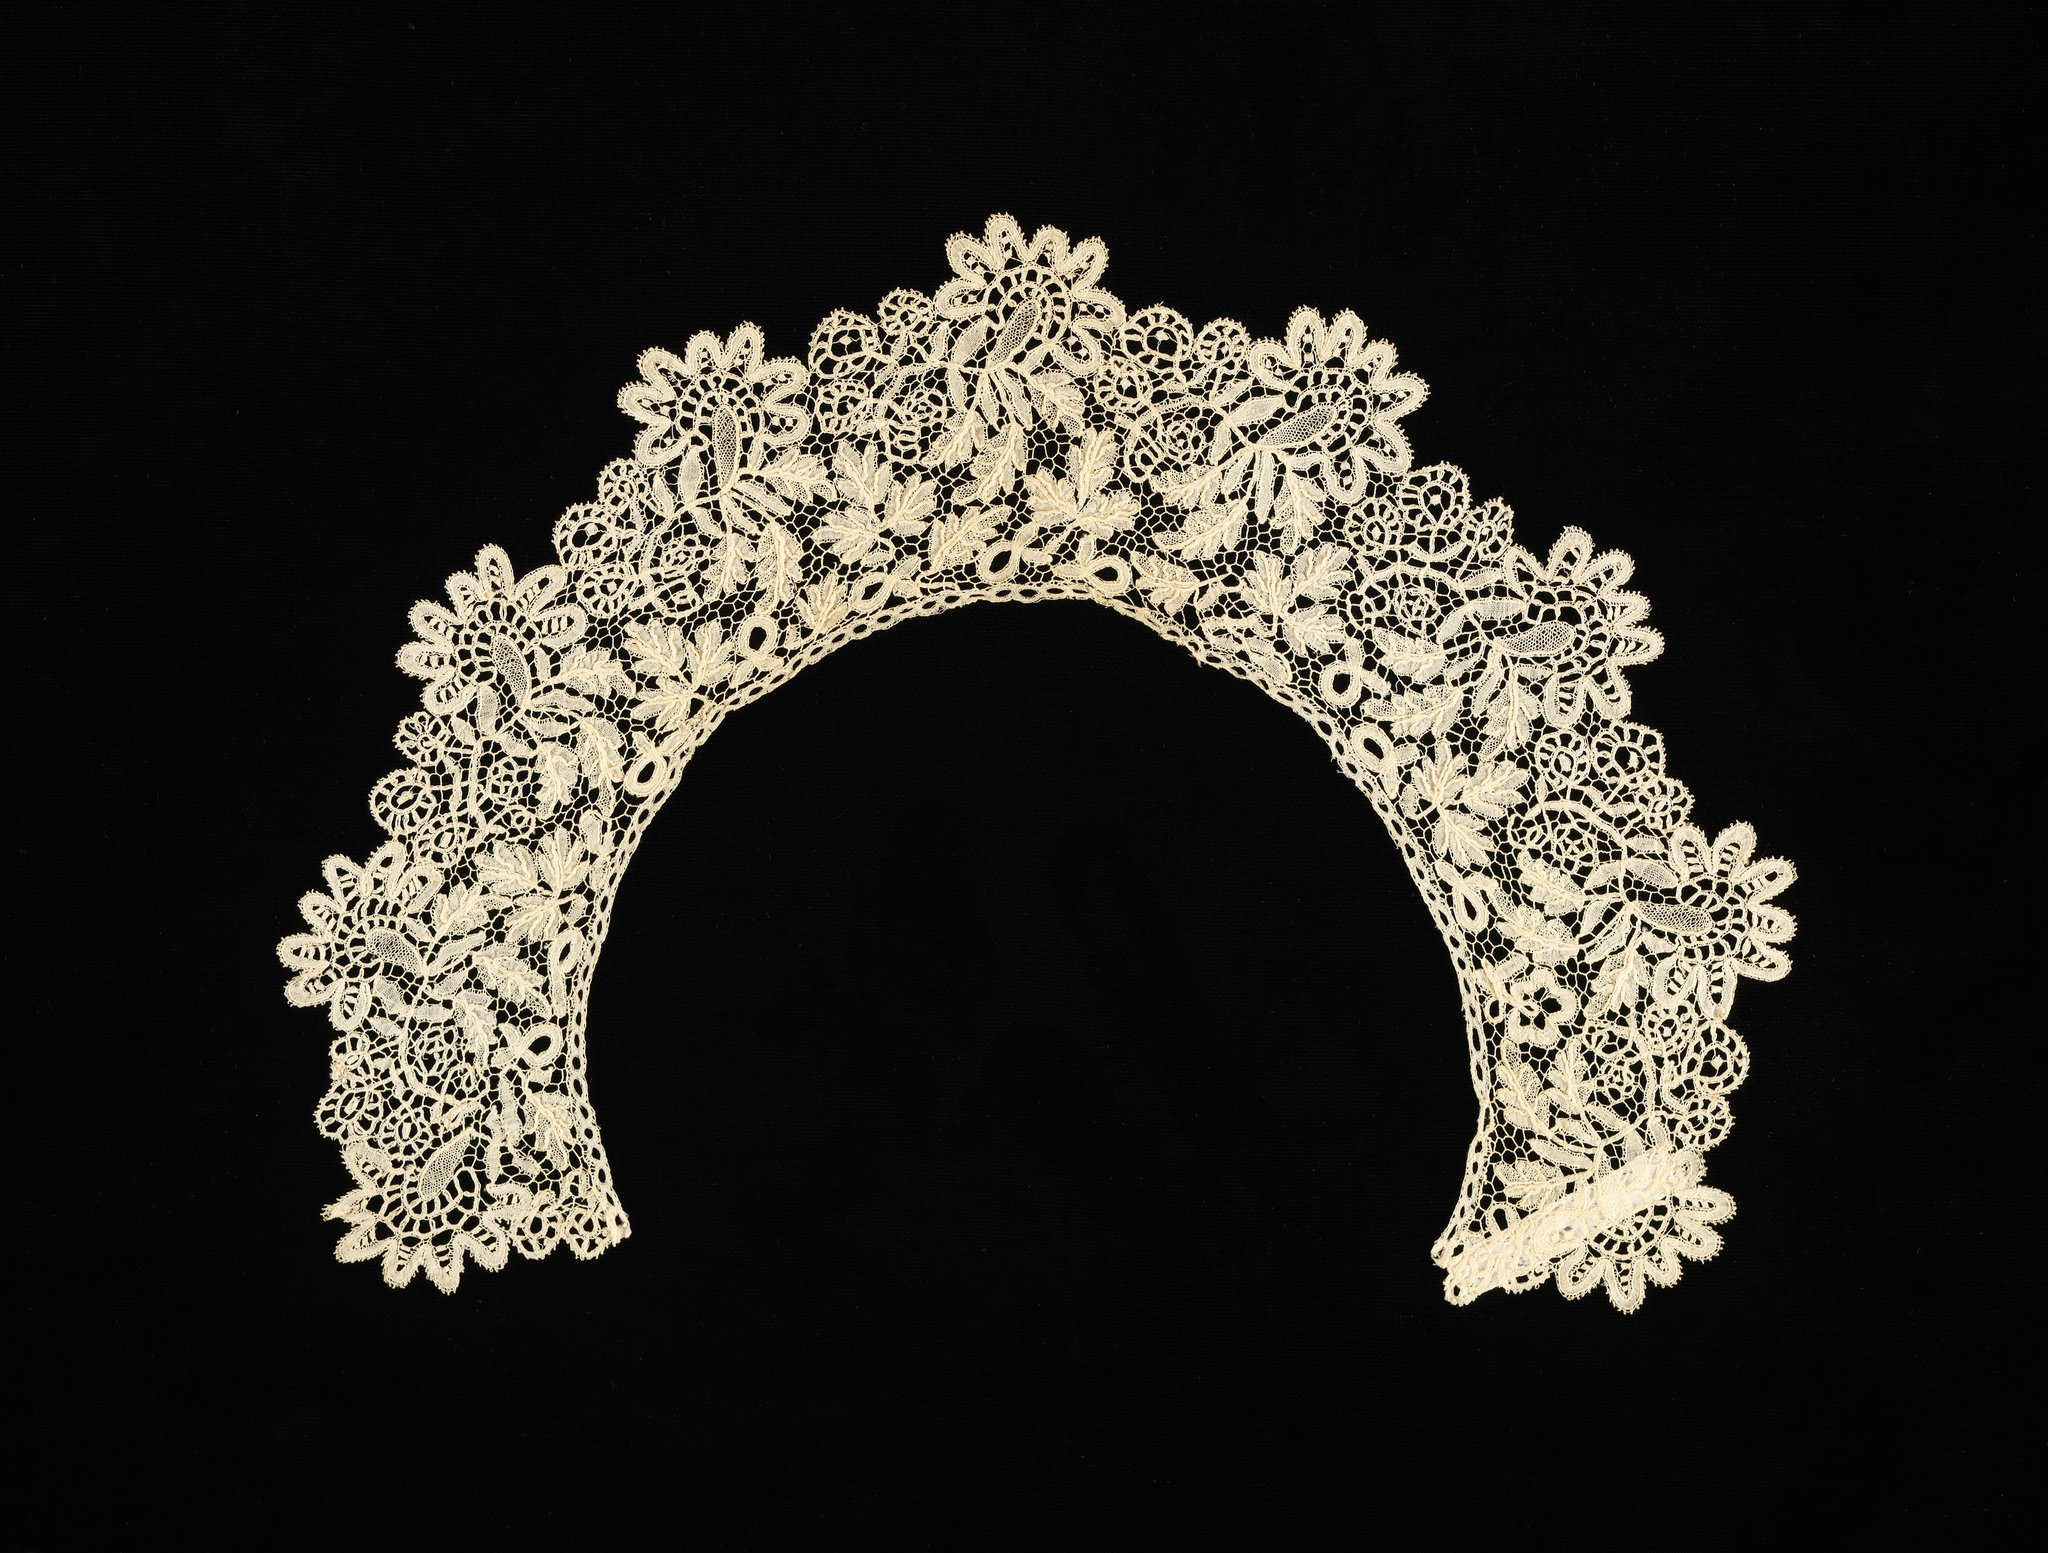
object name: collar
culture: belgian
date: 1876-1900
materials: cotton